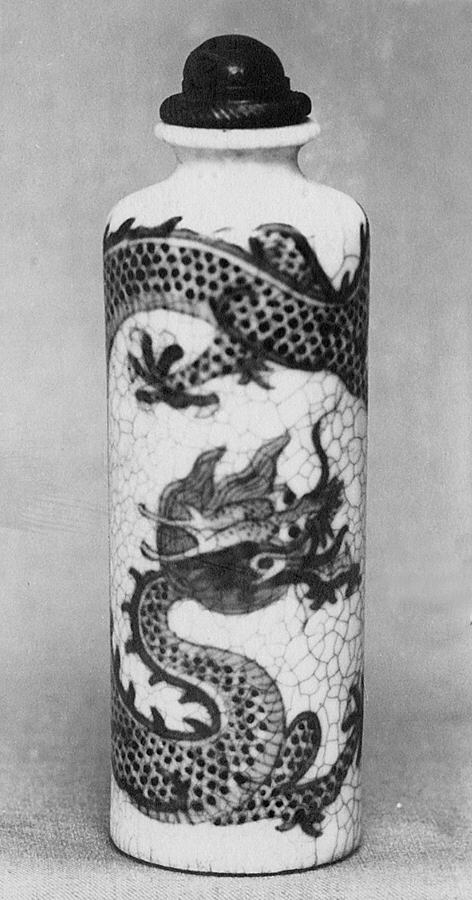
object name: snuff bottle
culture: chinese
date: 1723-1735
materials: soft paste porcelain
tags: dragons